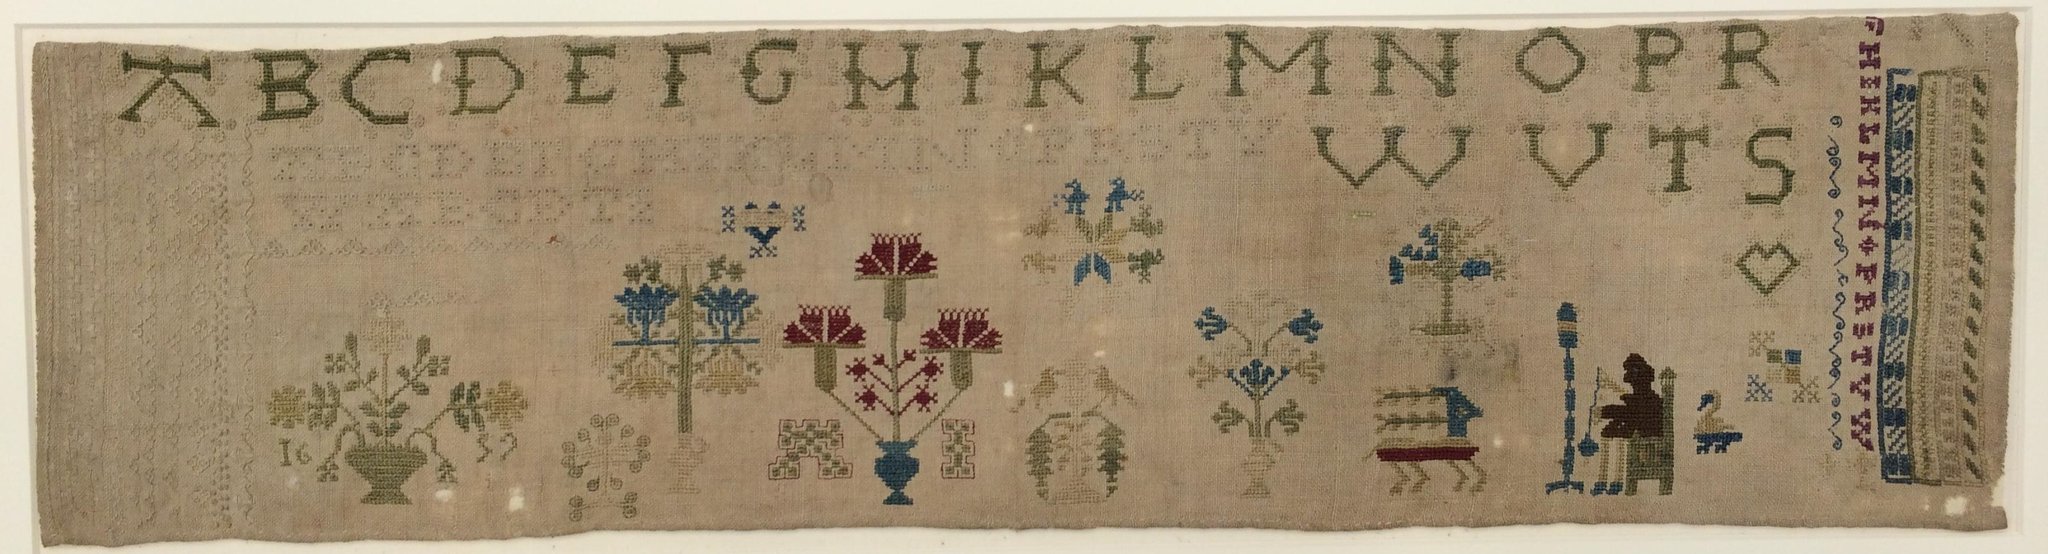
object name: sampler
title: Embroidered sampler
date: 1659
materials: linen, silk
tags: human figures,flowers